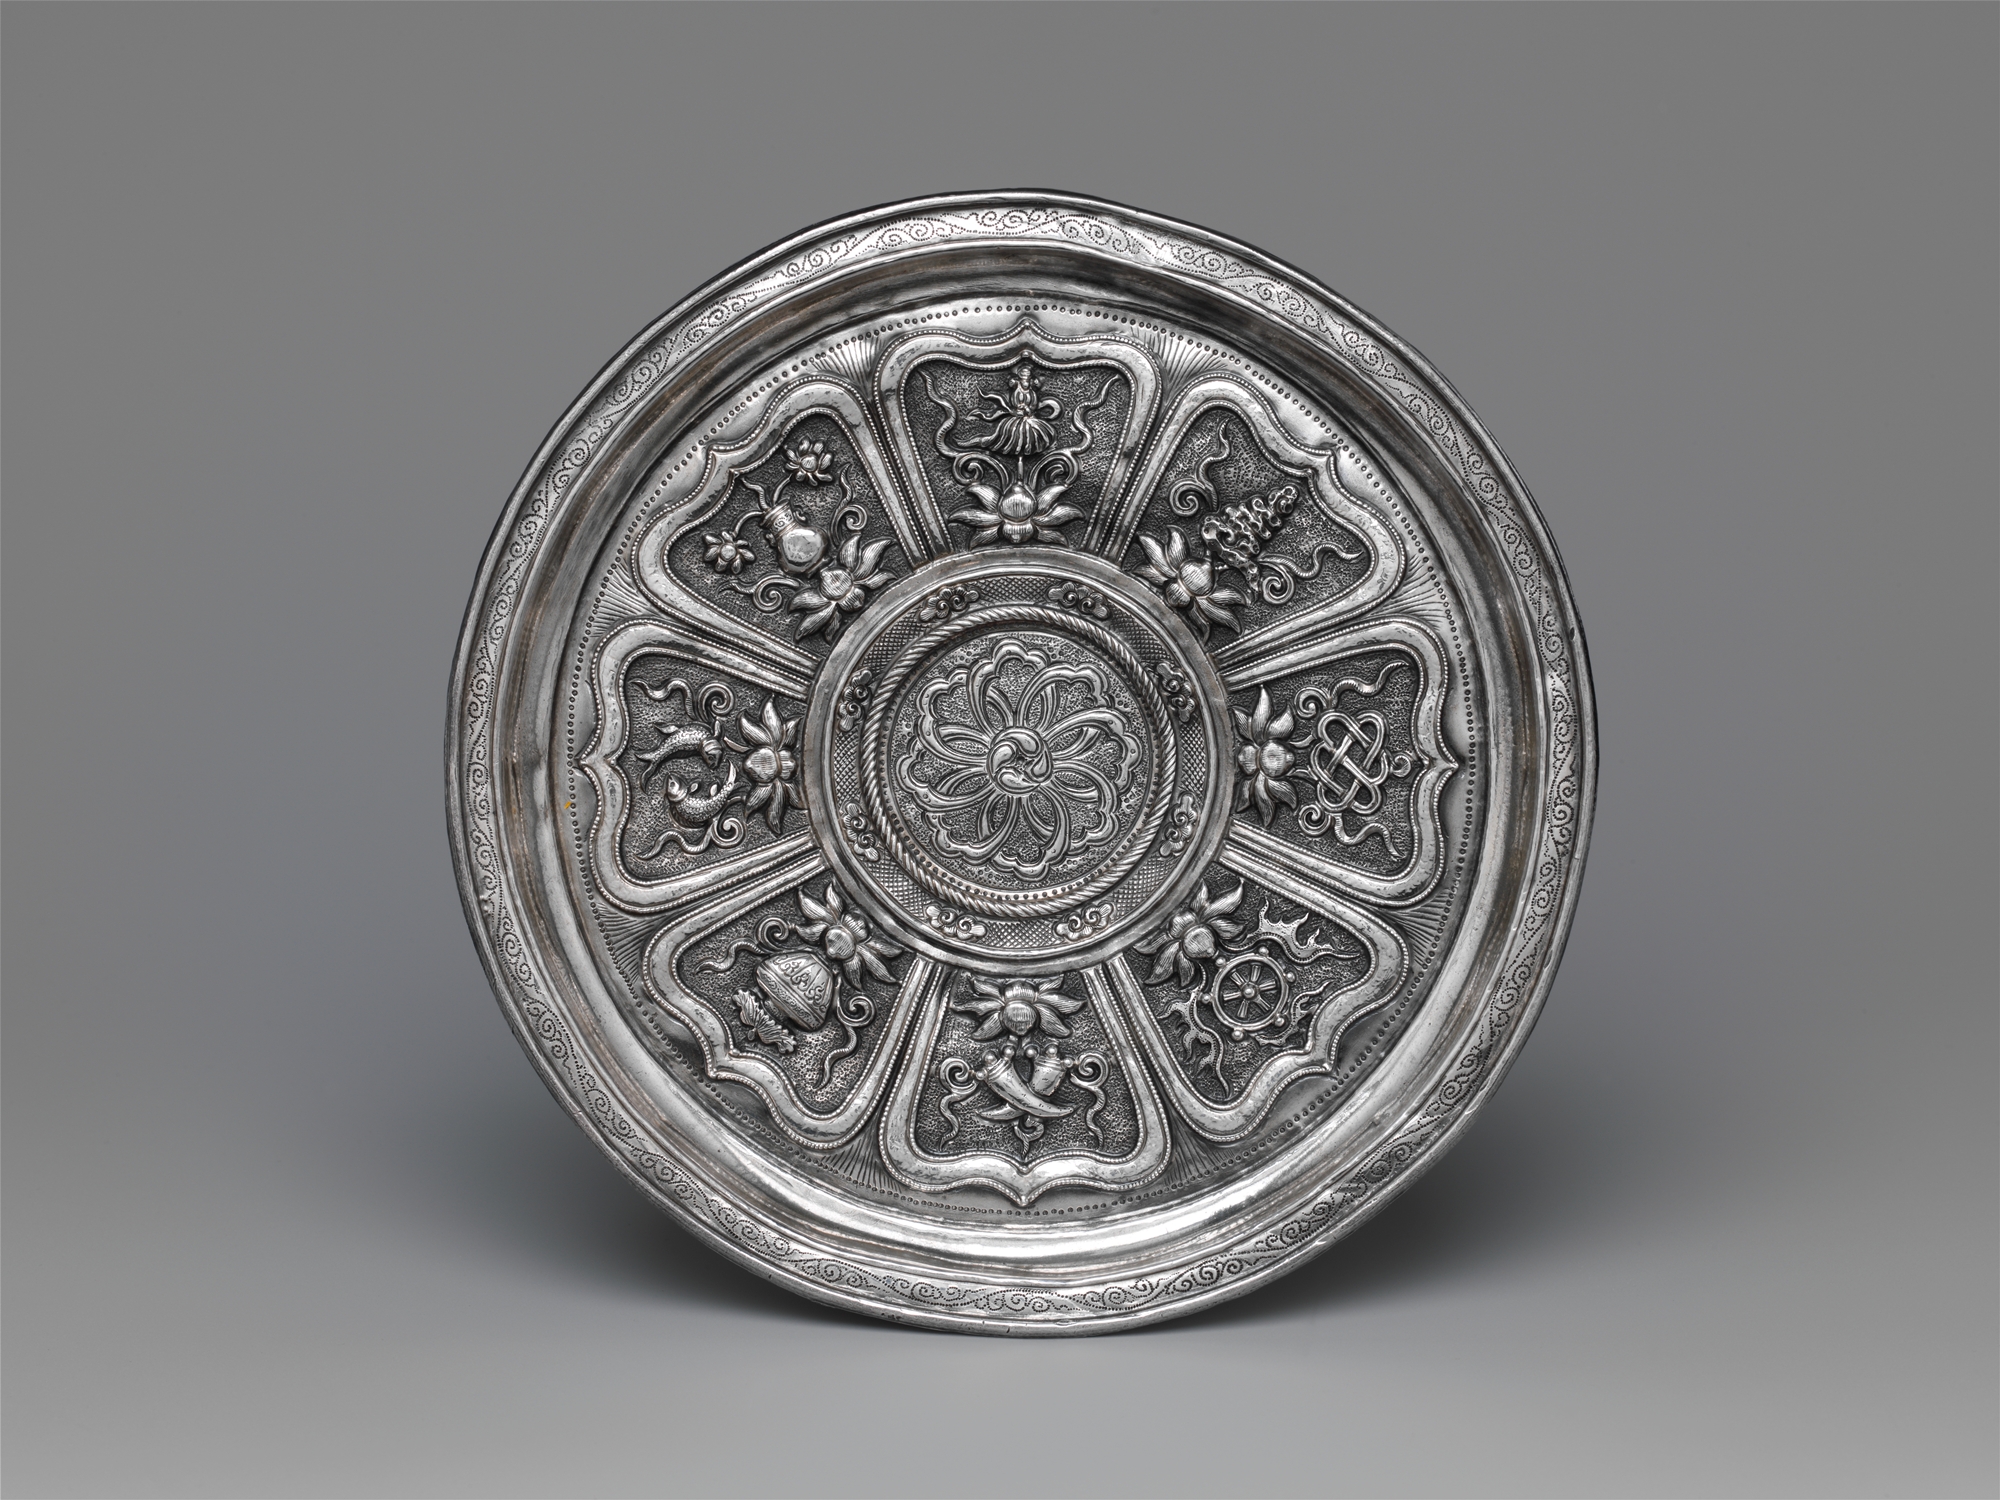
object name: cup stand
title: Cup Stand with the Eight Buddhist Treasures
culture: chinese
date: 1301-1400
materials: silver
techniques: repoussé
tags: fish,lotuses,buddhism